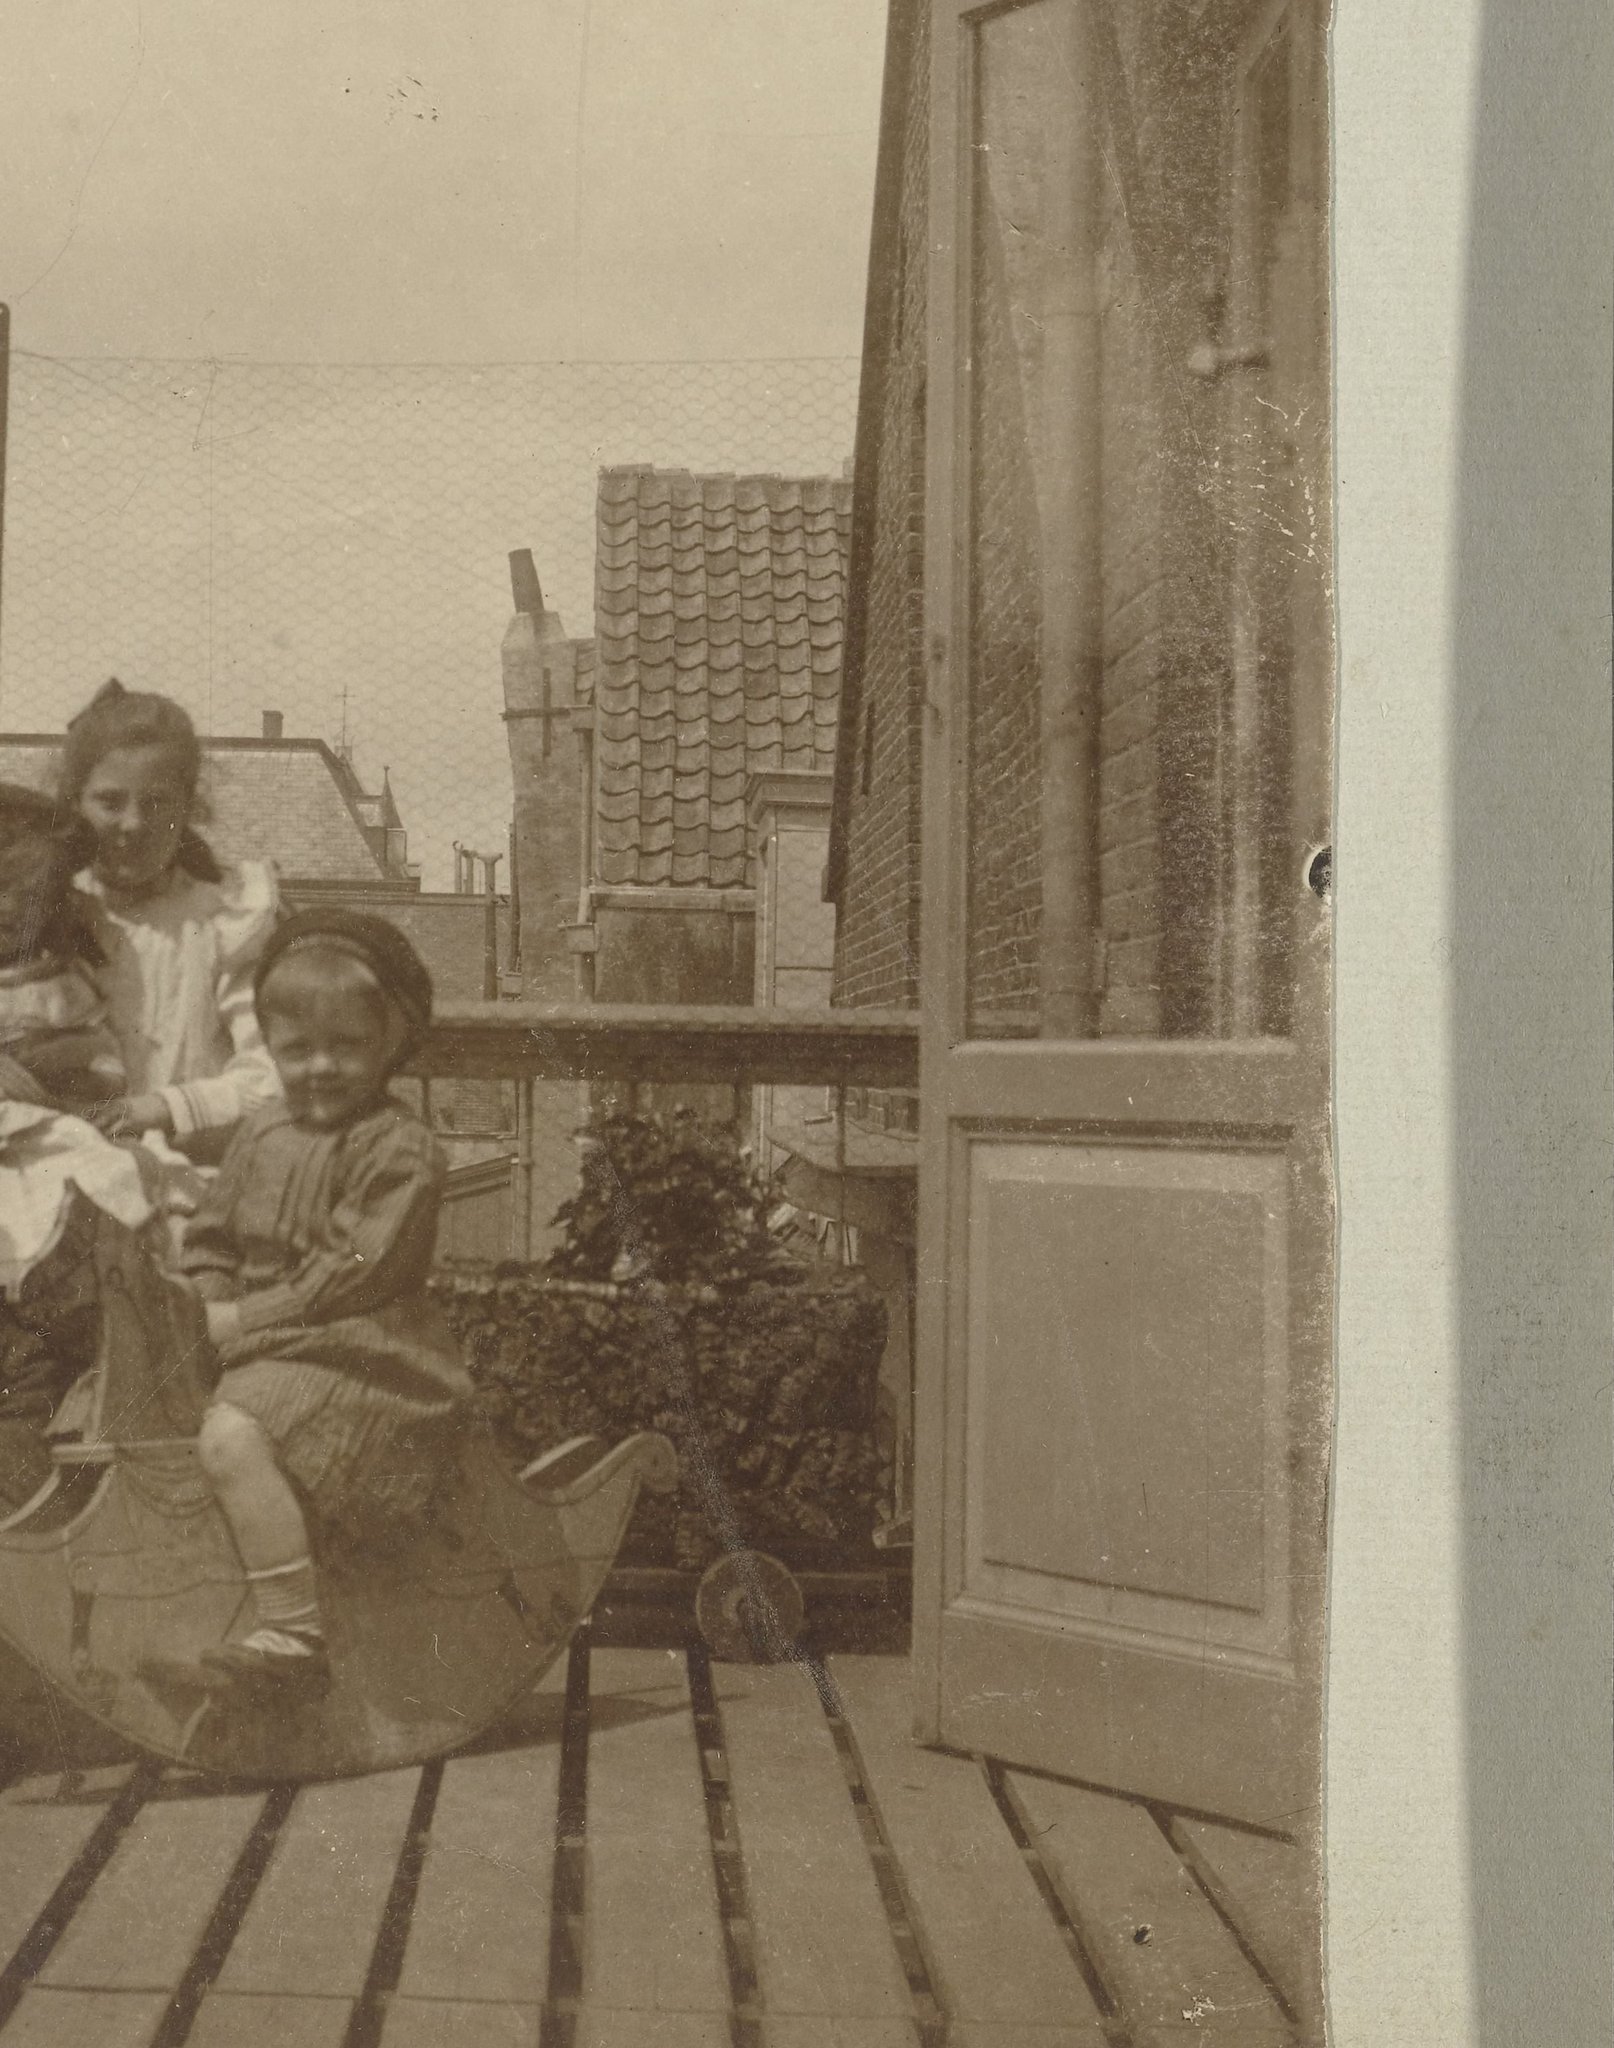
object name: album leaf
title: Groepsportret van vier kinderen van de familie Vermeulen op een balkon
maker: david vermeulen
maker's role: fotograaf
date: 1901-1910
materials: paper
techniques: gelatin silver print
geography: netherlands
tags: balcony, child between toddler and youth (of undetermined sex)